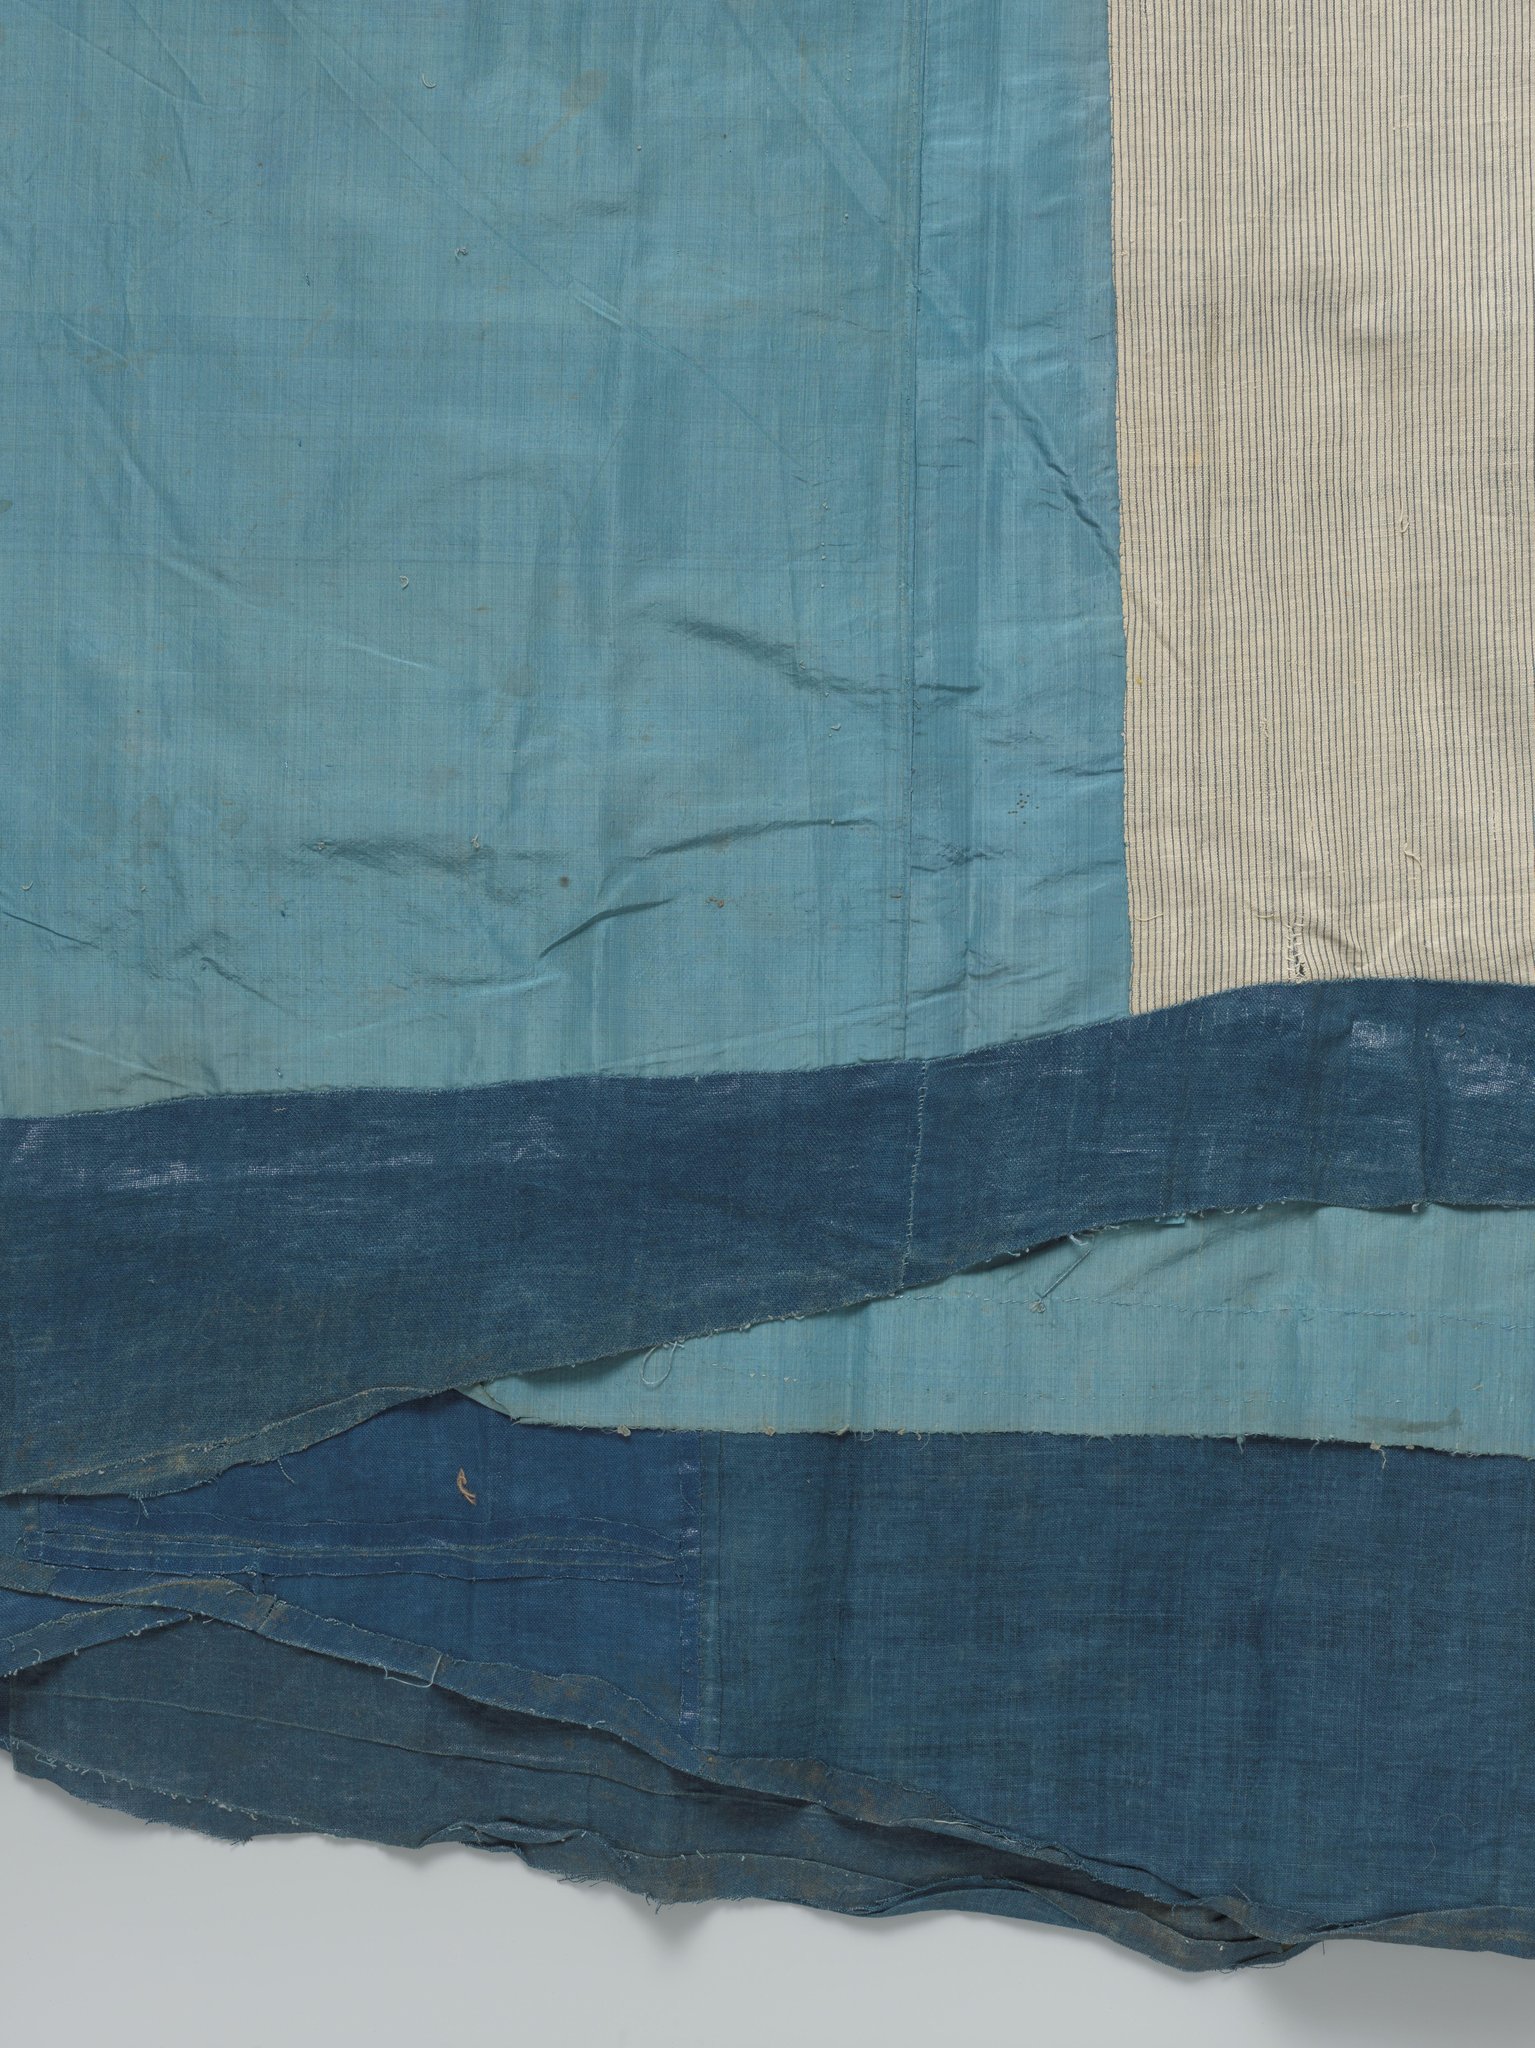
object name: liner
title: Voering van lichtblauwe tafzijde, aan de onderzijde een strook van gecalandeerd donkerblauw linnen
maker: Anonymous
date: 1750-1800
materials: linen, silk, textile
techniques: sewing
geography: netherlands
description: Voering van lichtblauwe tafzijde, aan de onderzijde een strook van gecalandeerd donkerblauw linnen; vijfbaans, waarvan één blauwwit gestreepte baan.